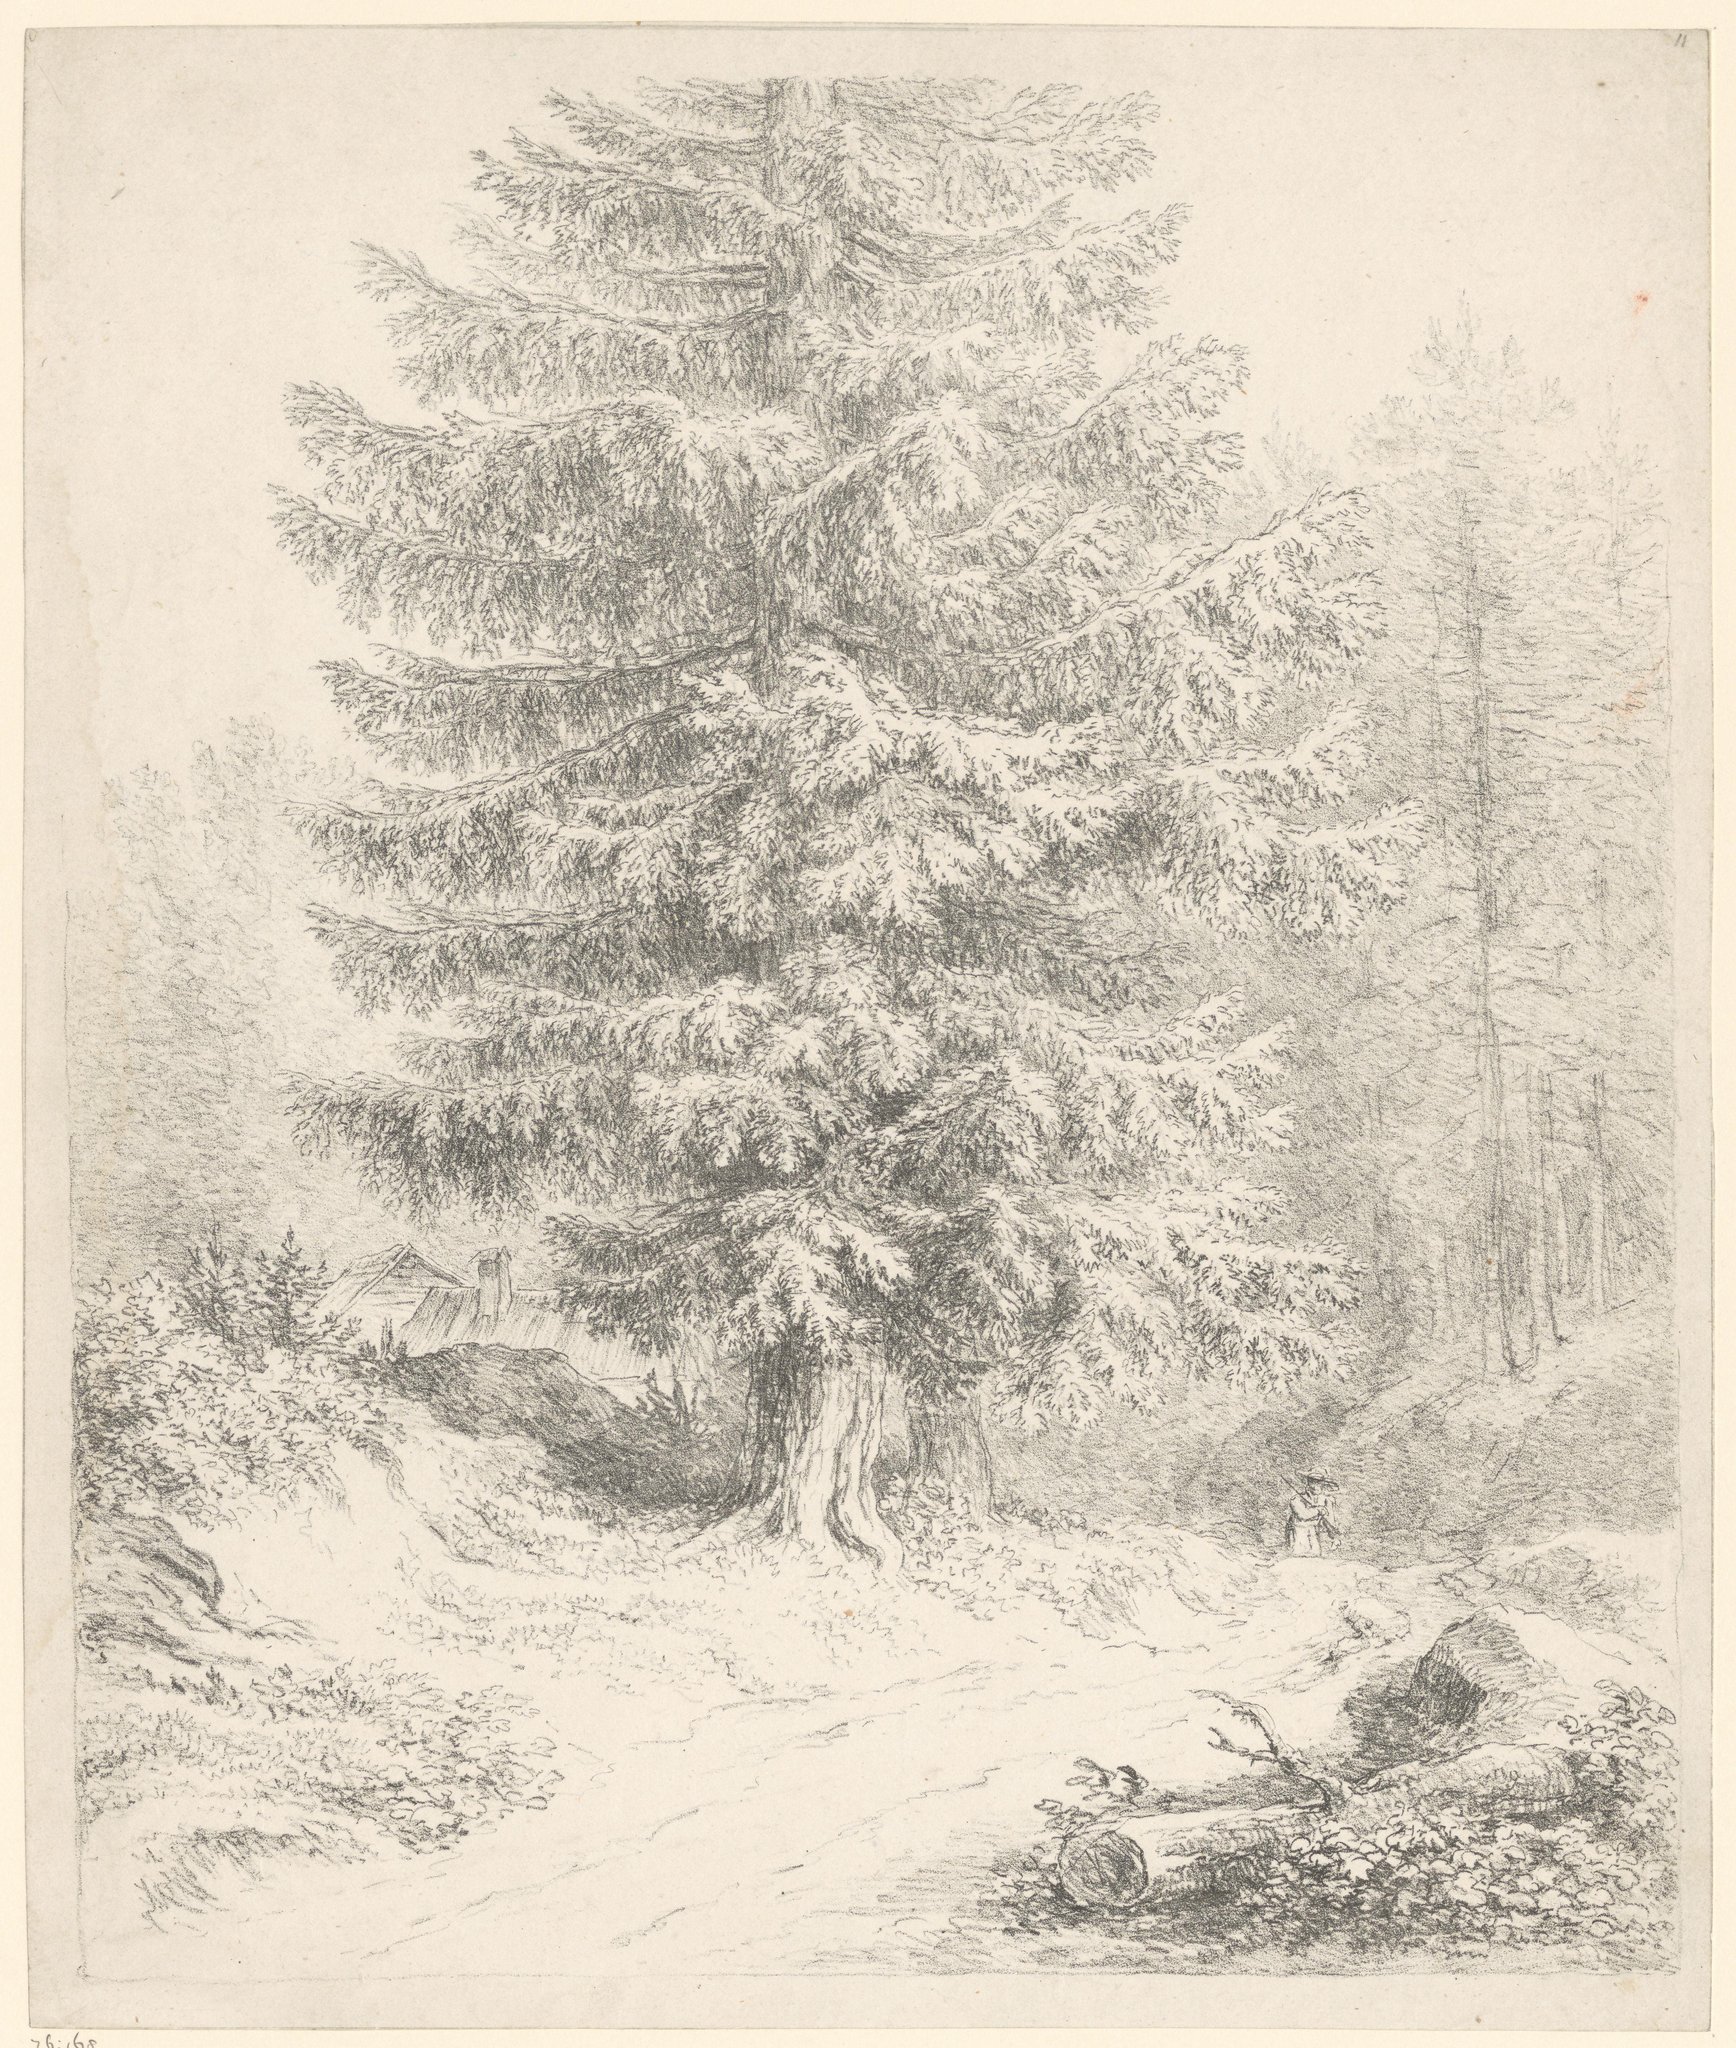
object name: print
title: Landschappen door Joseph Mössmer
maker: joseph mössmer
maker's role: print maker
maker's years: 1780-1845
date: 1818-1821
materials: paper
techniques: lithograph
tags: hunter, landscapes in the temperate zone (+ landscape with figures, staffage), trees: pine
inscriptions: collector's mark: Lugt 2228, collector's mark: Lugt 2760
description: Deze prent behoort waarschijnlijk tot een serie met zeventien landschappen door Joseph Mössmer uit ca. 1818-1821. Mogelijk is dit de vijftiende prent in de serie.